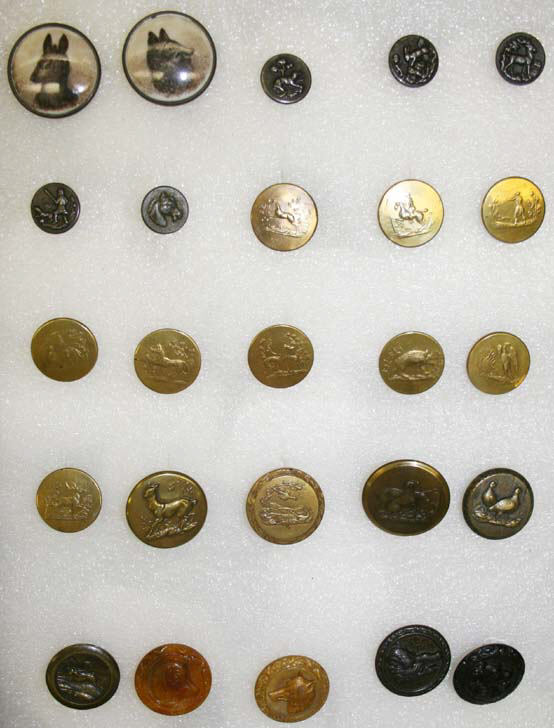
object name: button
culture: british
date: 1850-1900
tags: animals,birds,men,hunting